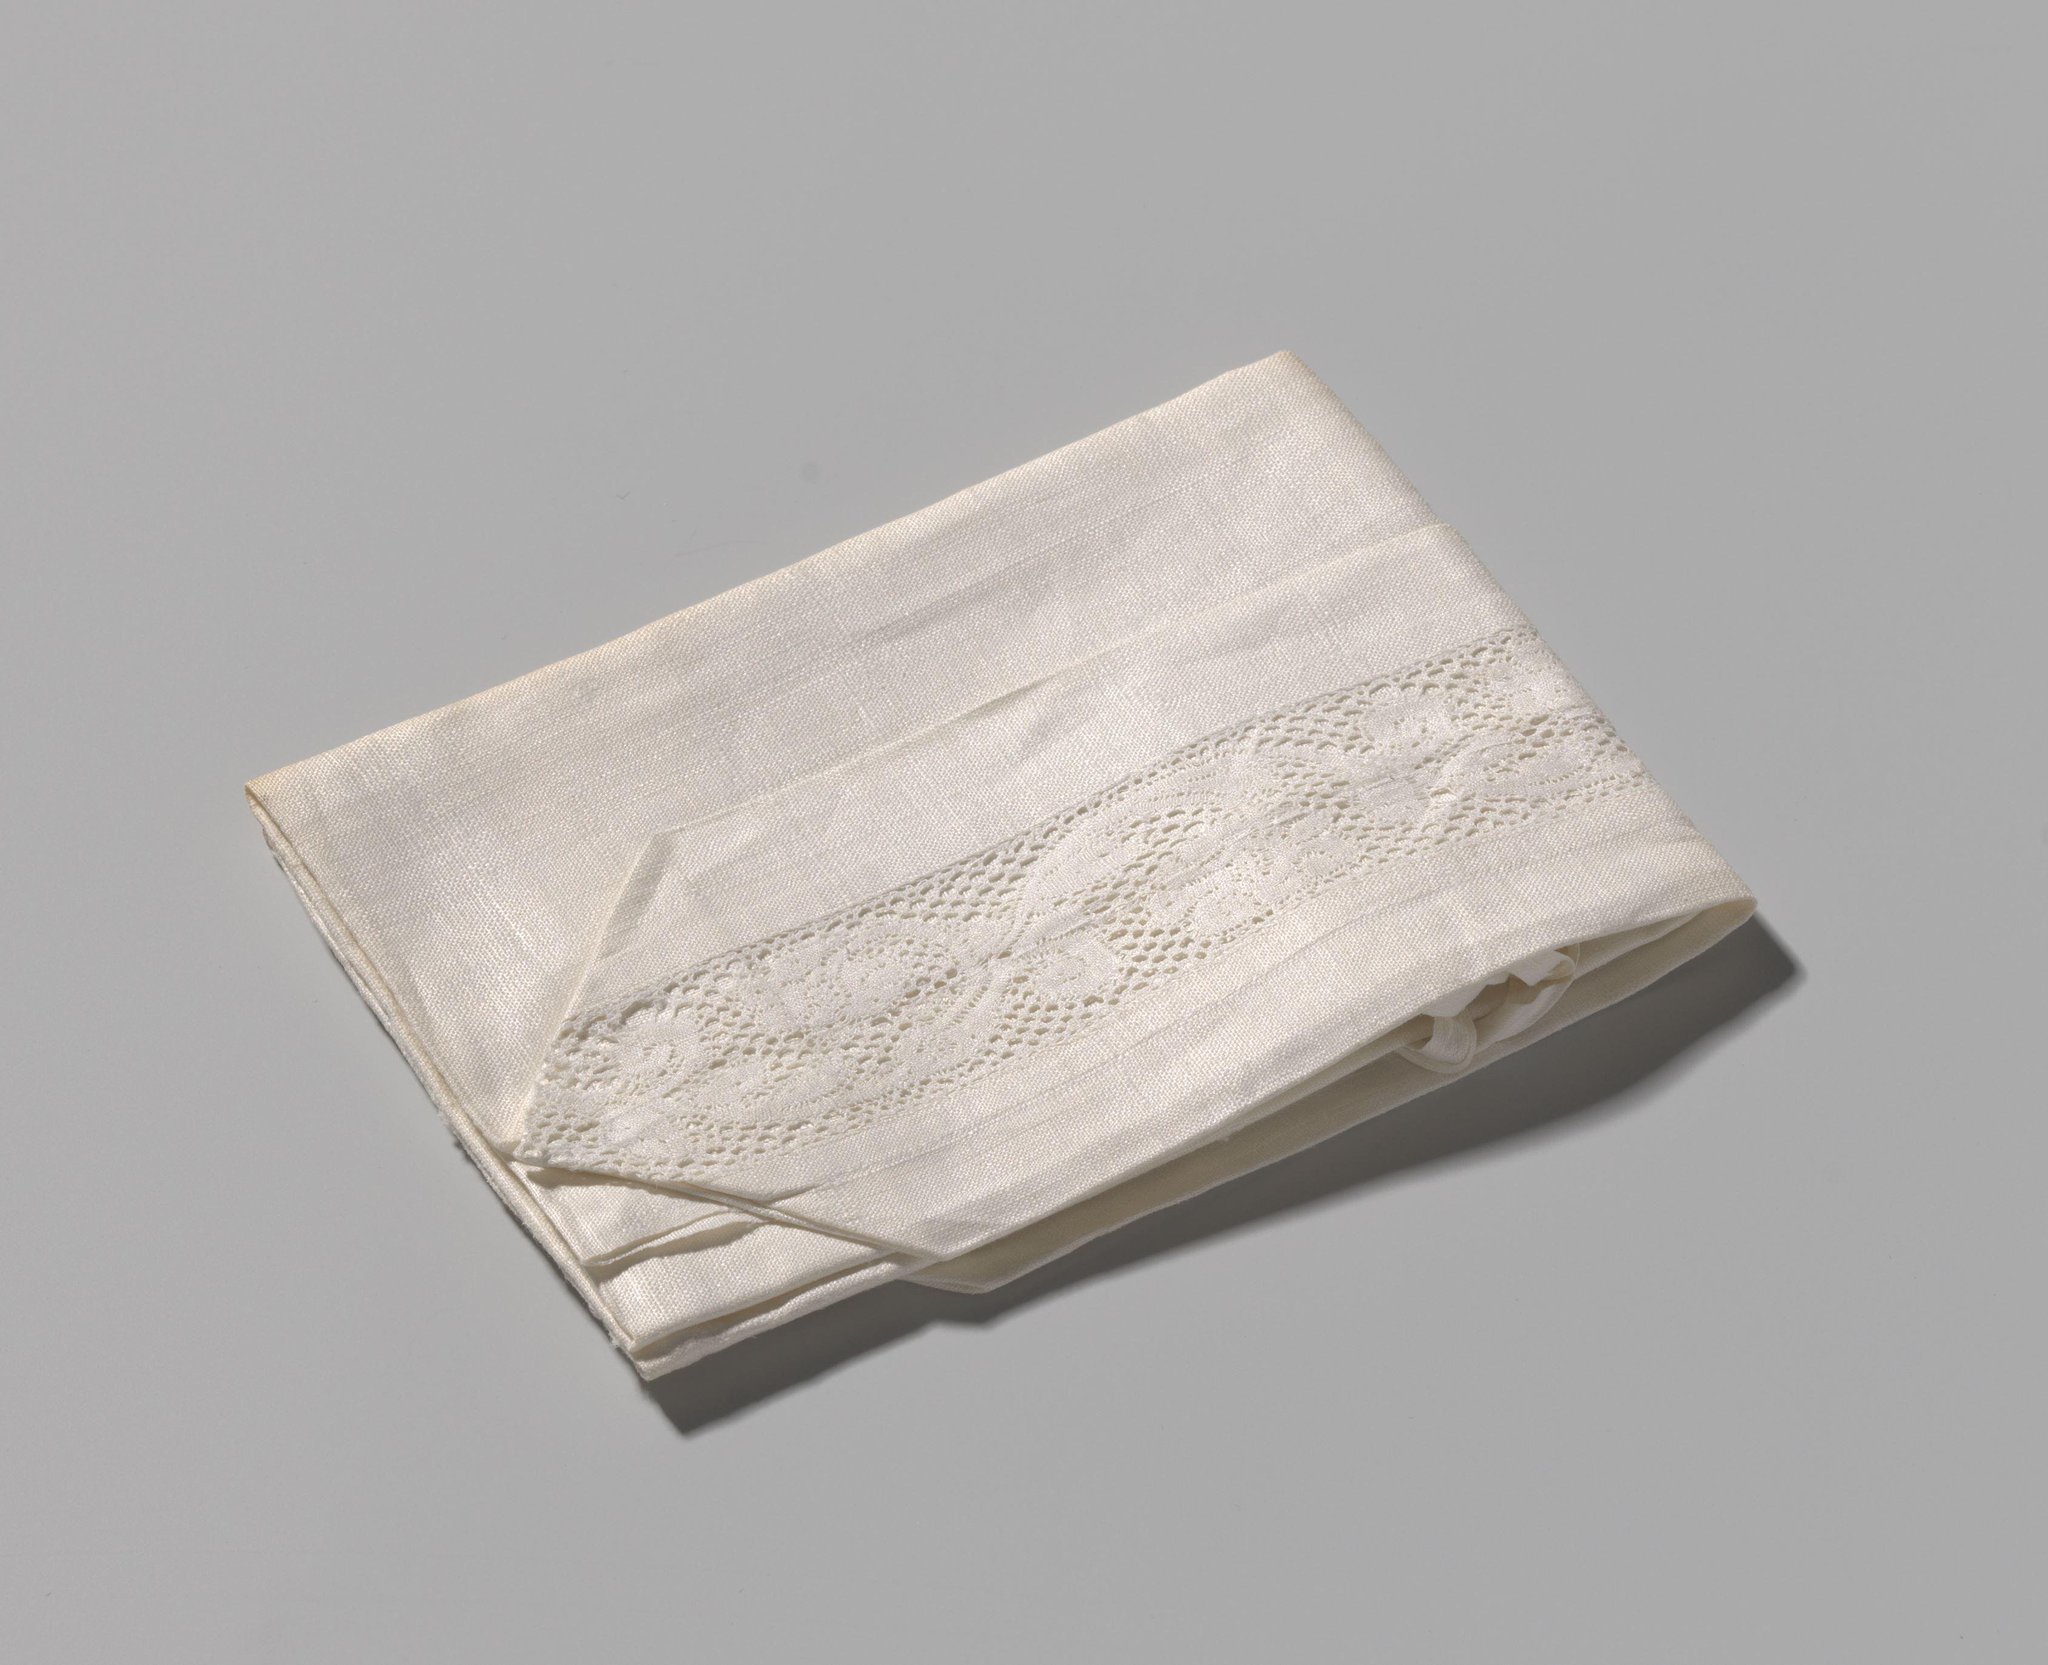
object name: sloop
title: Sloop met tussenzetsel. Merk: kroon B6 SH2oonl.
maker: Anonymous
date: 1600-1699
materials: linen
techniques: lace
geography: netherlands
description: Sloop van wit linnen met tussenzetsel van Vlaamse kloskant met bloempatroon, merk kroon b 6 WH 2oonl